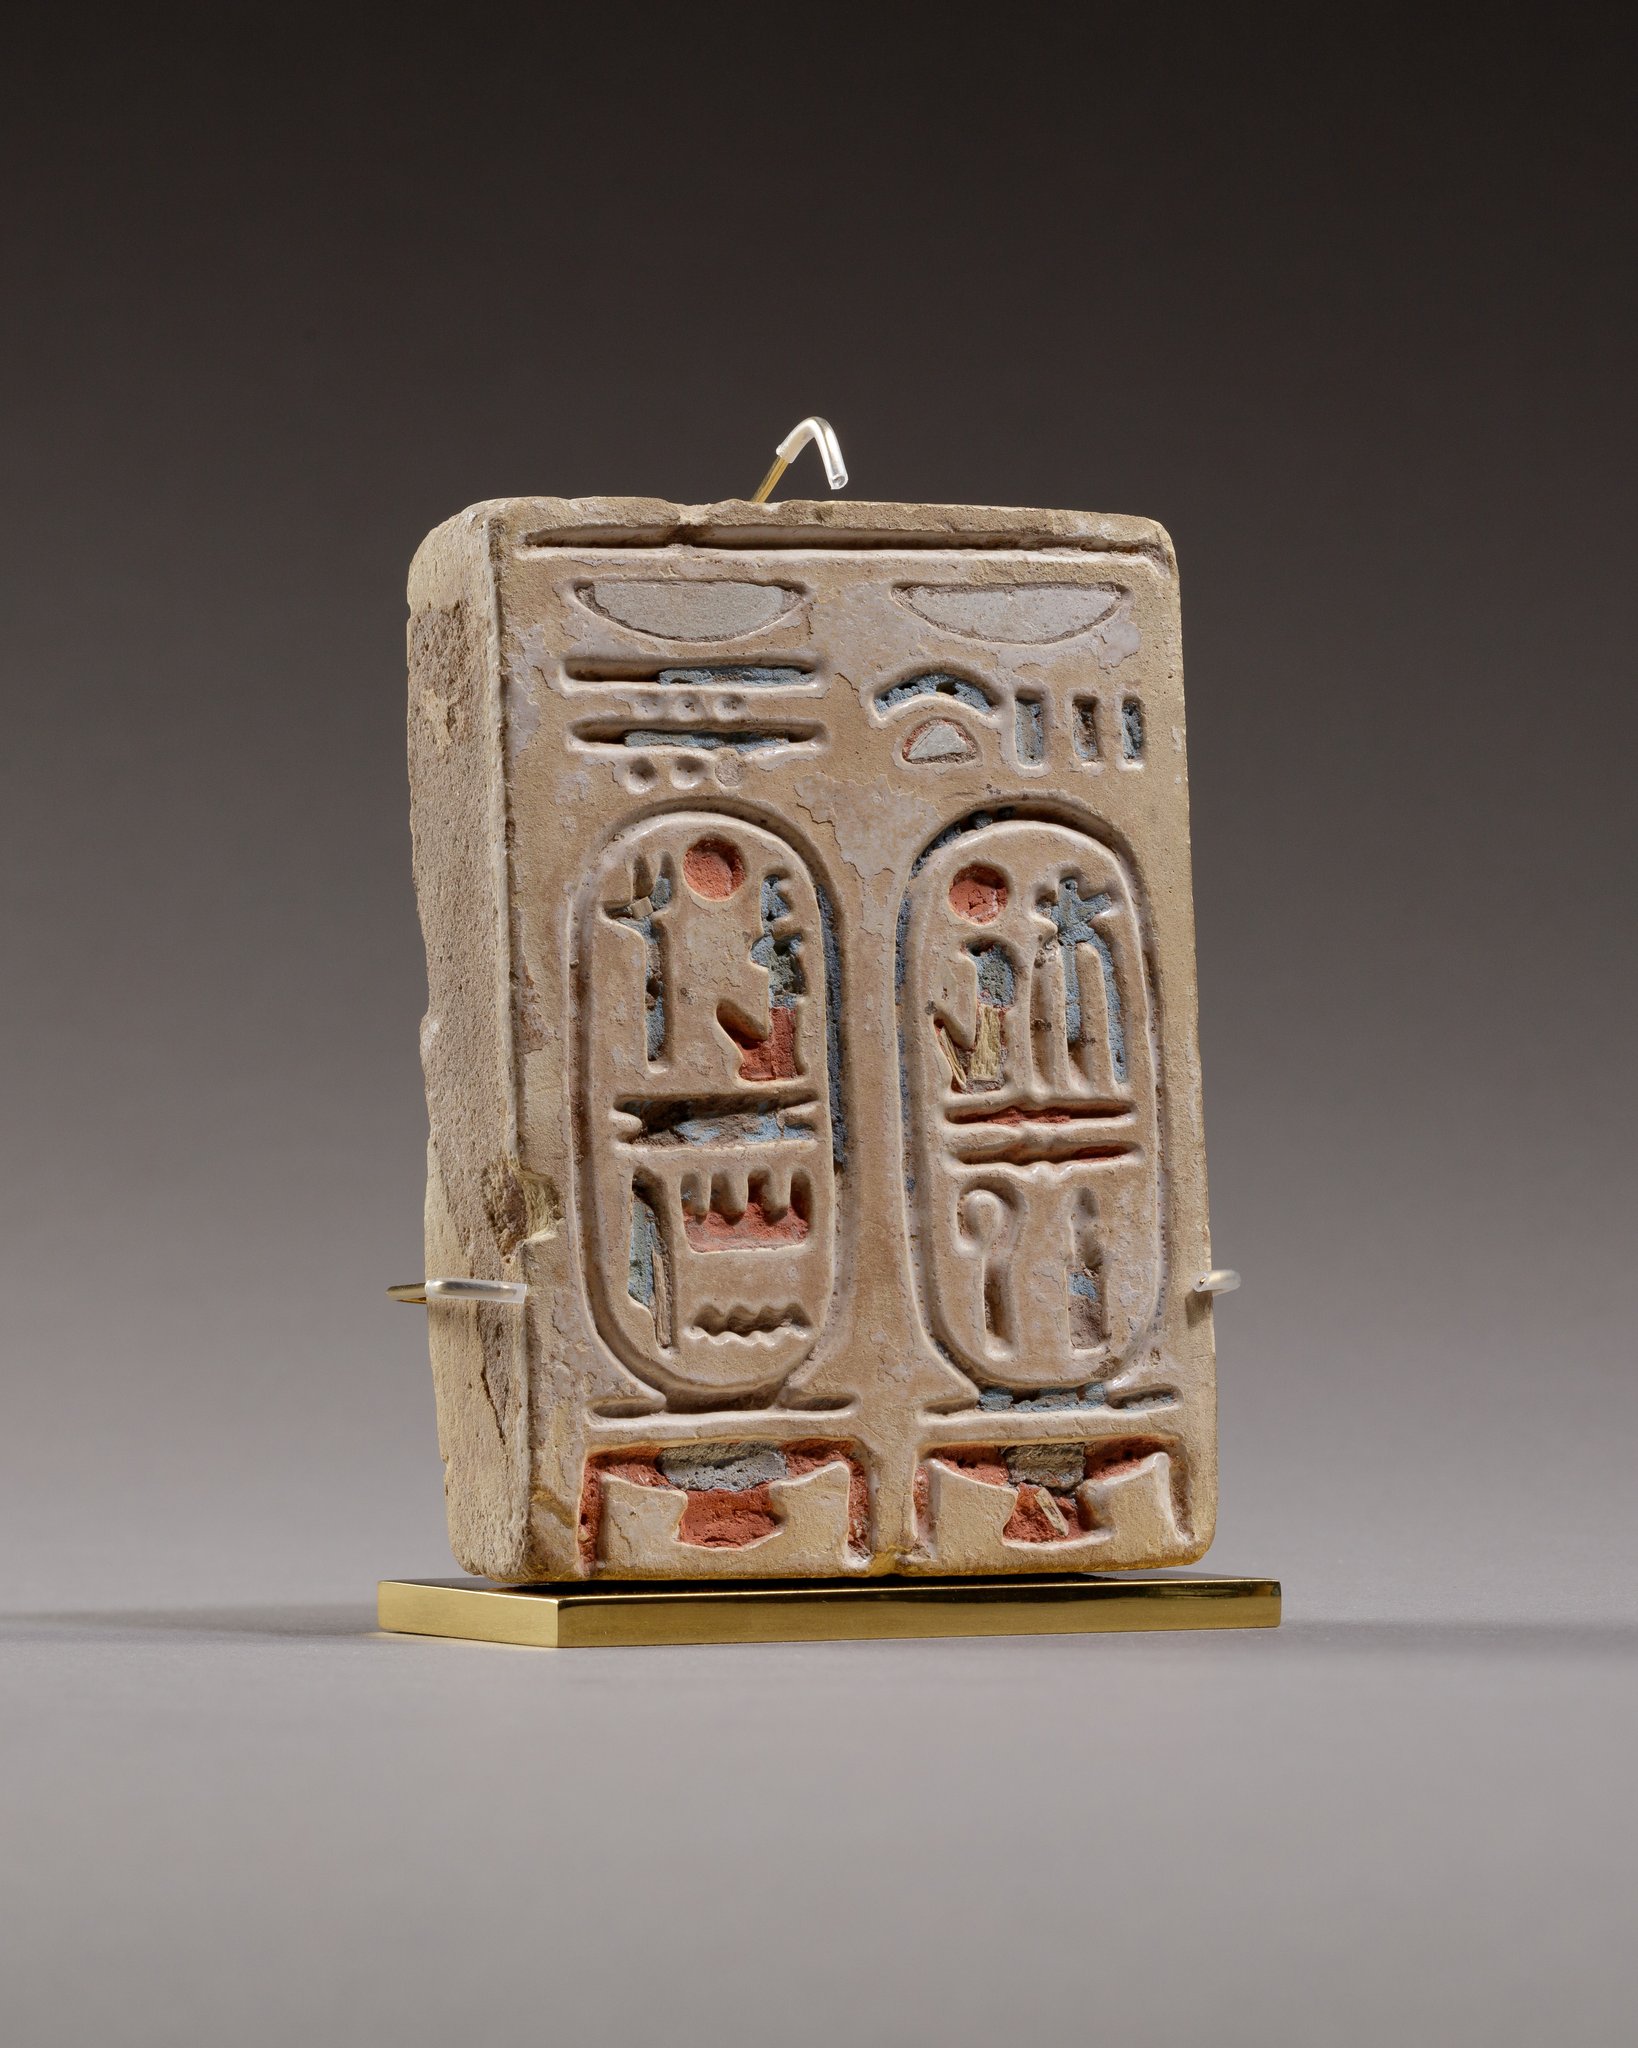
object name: tile, ramesses iii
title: Tile with the names of Ramesses III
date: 1184-1153 BCE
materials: faience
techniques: inlay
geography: upper egypt, thebes